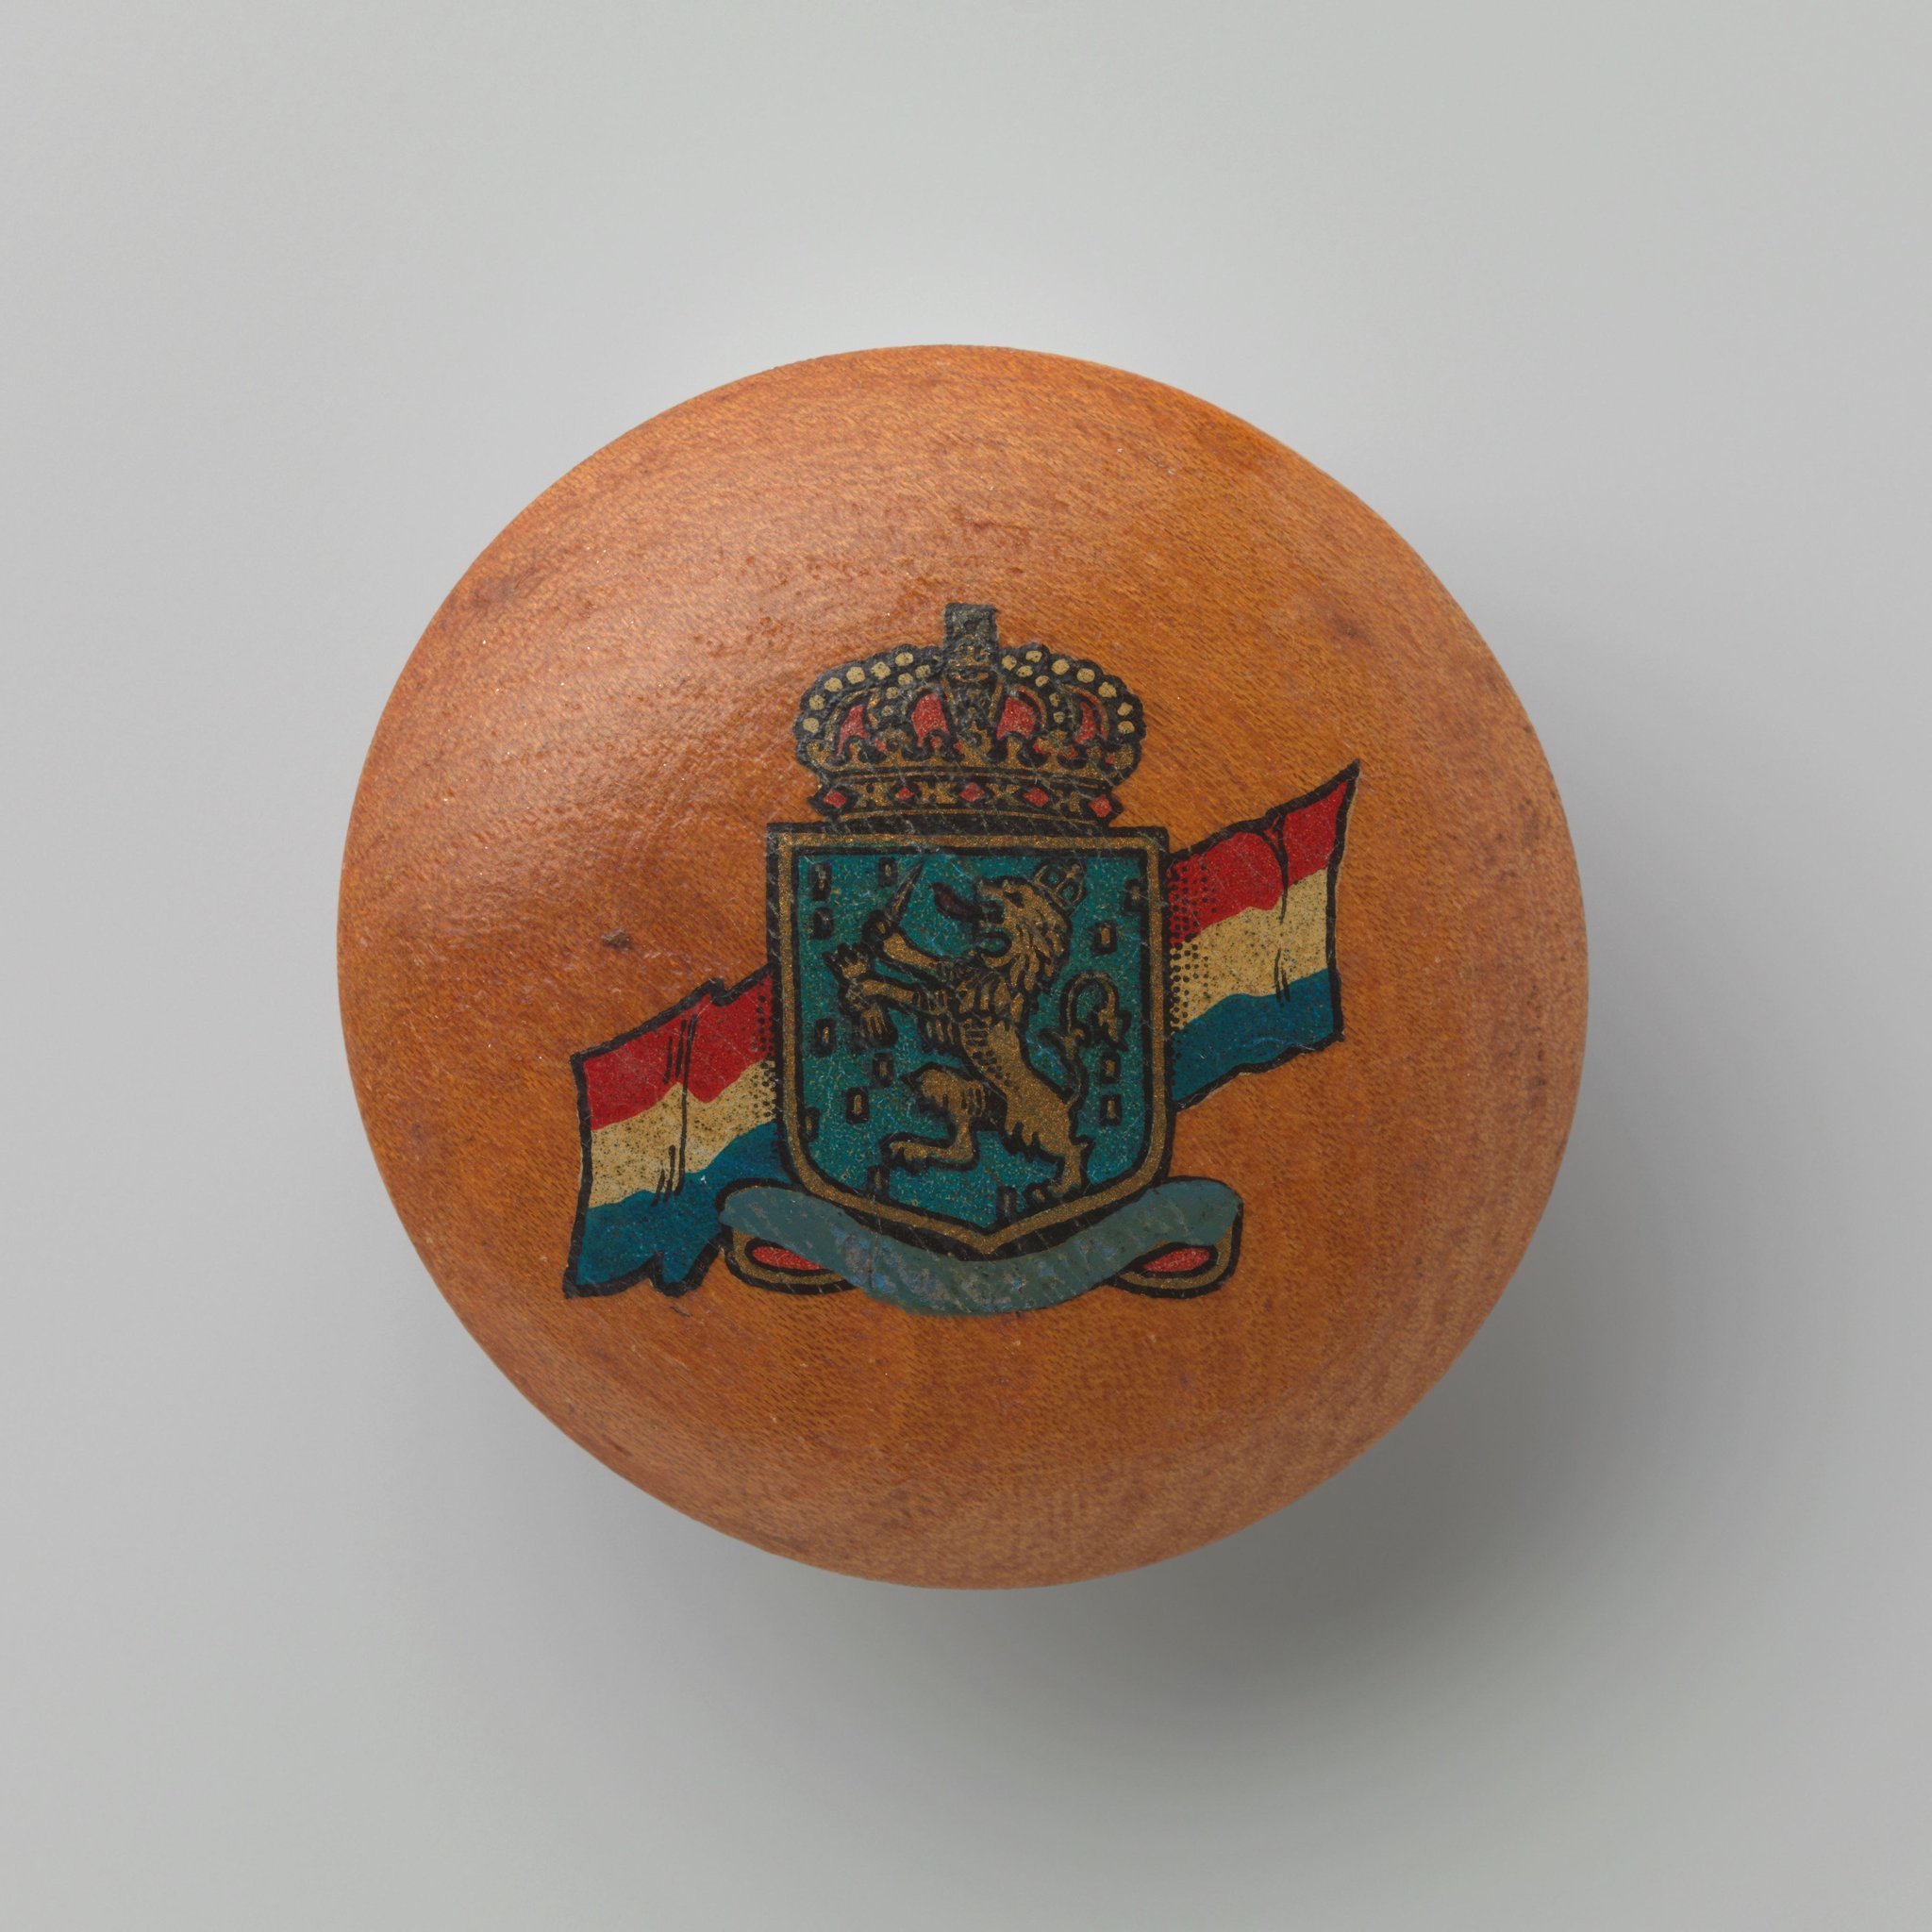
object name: brooch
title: Broche van hout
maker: Anonymous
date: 1944-1945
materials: metal, wood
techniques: painted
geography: netherlands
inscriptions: : ‘DEPT’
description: Ronde convexe broche van gelakt blank hout met het Rijkswapen erop geschilderd in verschillende kleuren, voorzien van een gelijmde haaksluiting van onedel metaal.